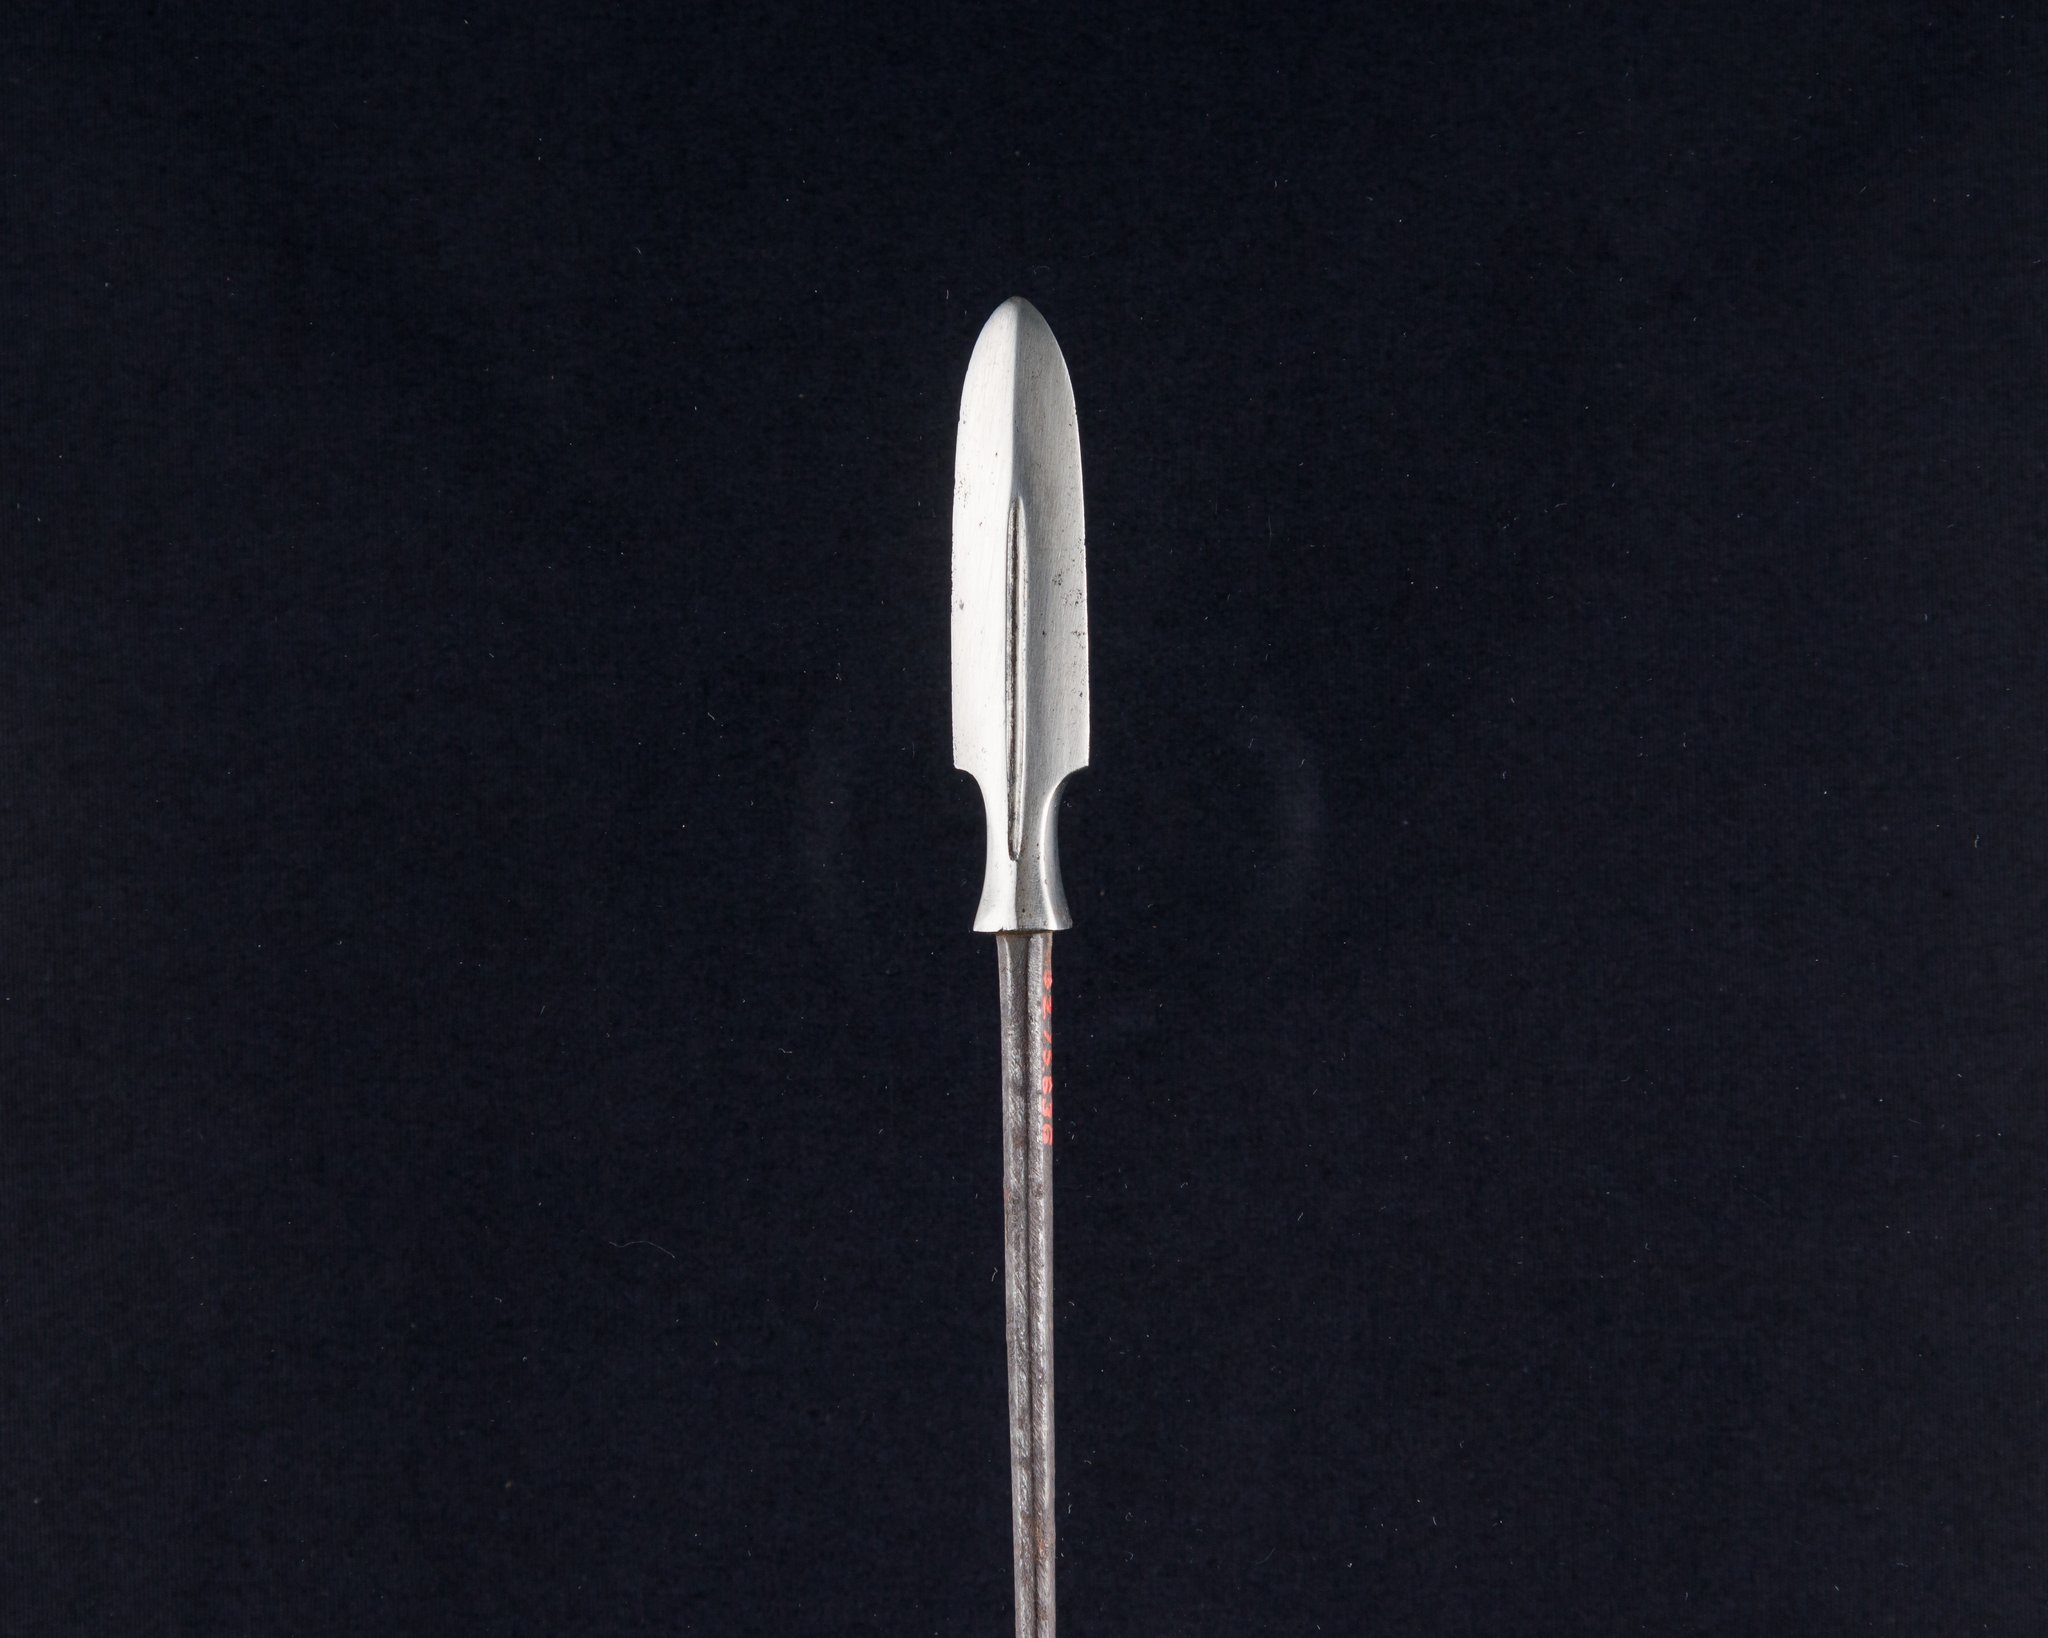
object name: arrowhead i yanone i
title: Arrowhead (Yanone)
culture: japanese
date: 1701-1800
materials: steel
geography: japan